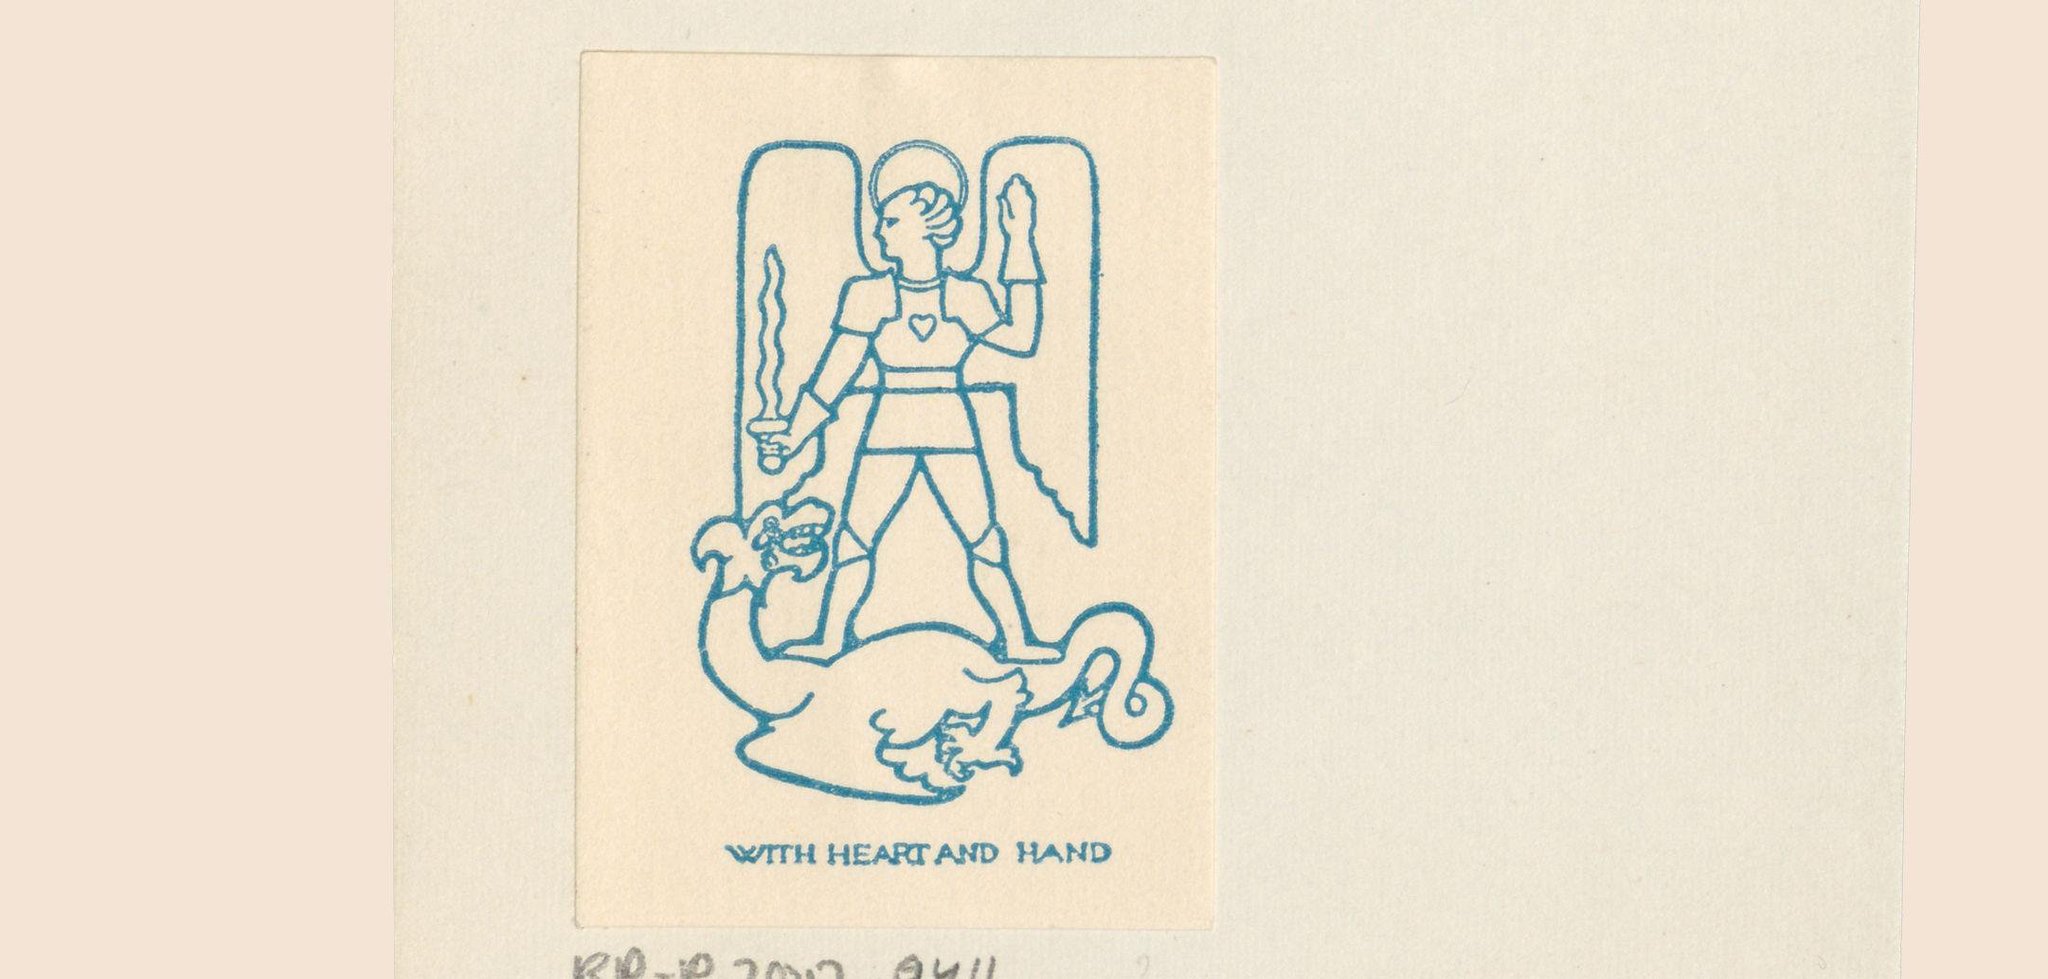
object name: bookplate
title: Ex libris van onbekend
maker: Anonymous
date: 1900-1999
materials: paper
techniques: printing block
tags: the virgin mary, hacking and thrusting weapons: sword, the warrior martyr george (georgius); possible attributes: banner (red cross on white field), (red) cross, dragon, (white) horse, broken lance, shield (with cross), sword